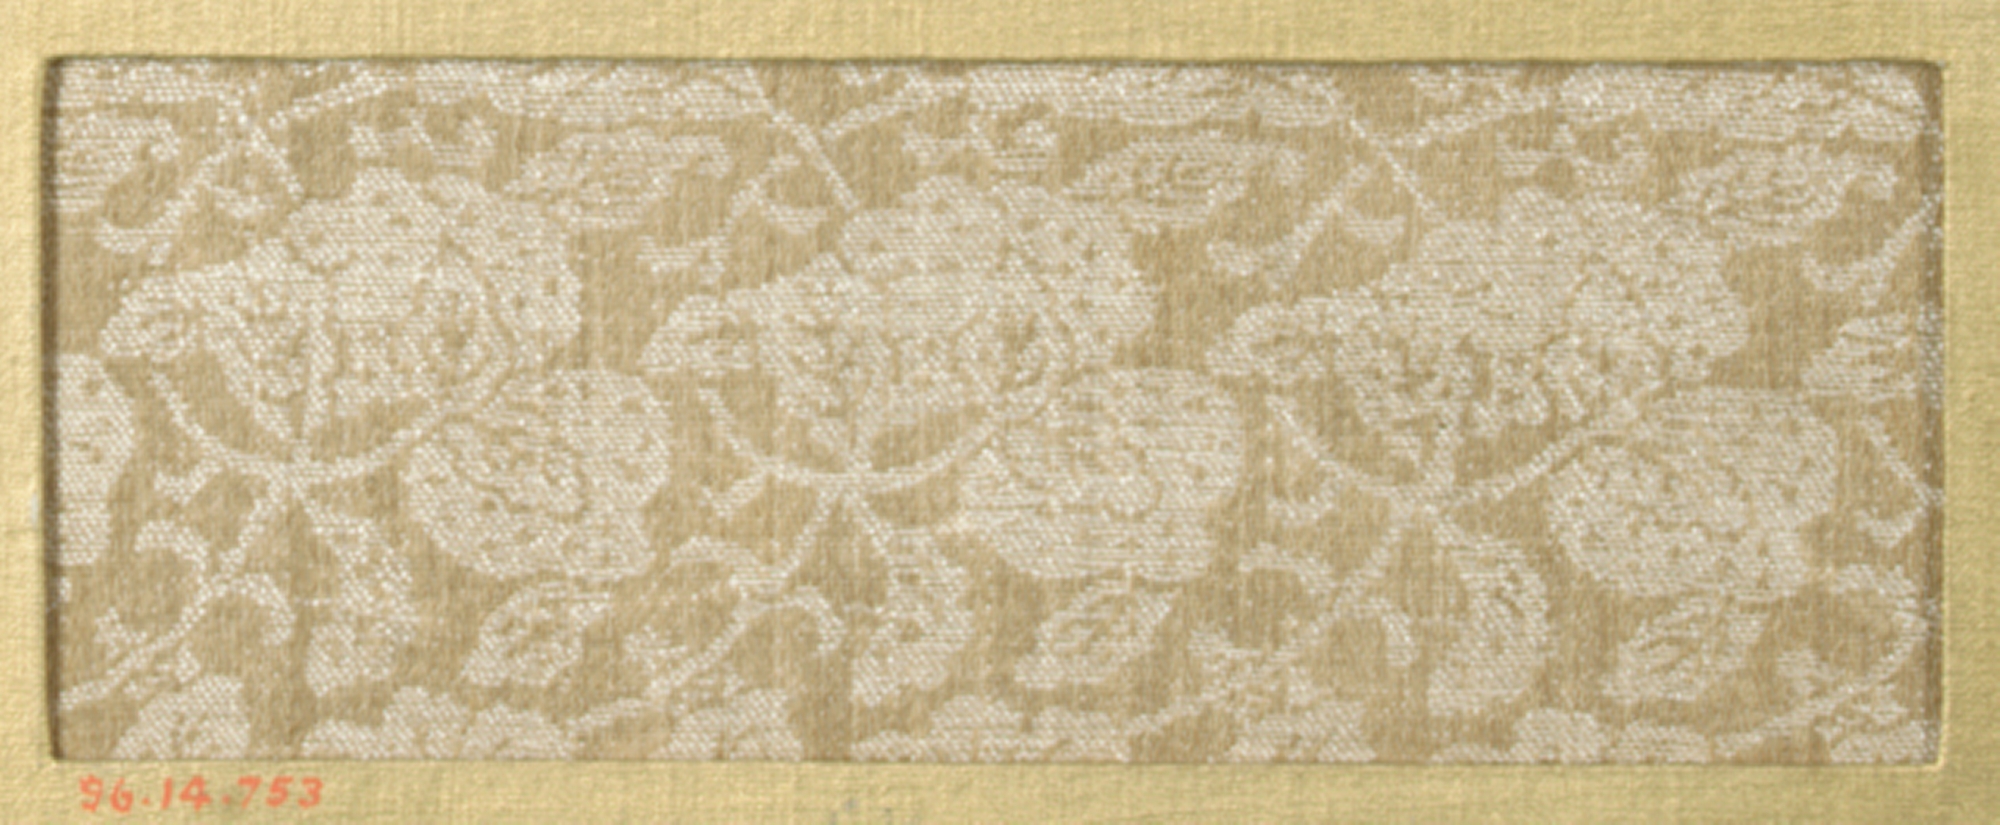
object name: piece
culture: japanese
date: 1701-1900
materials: silk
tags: flowers